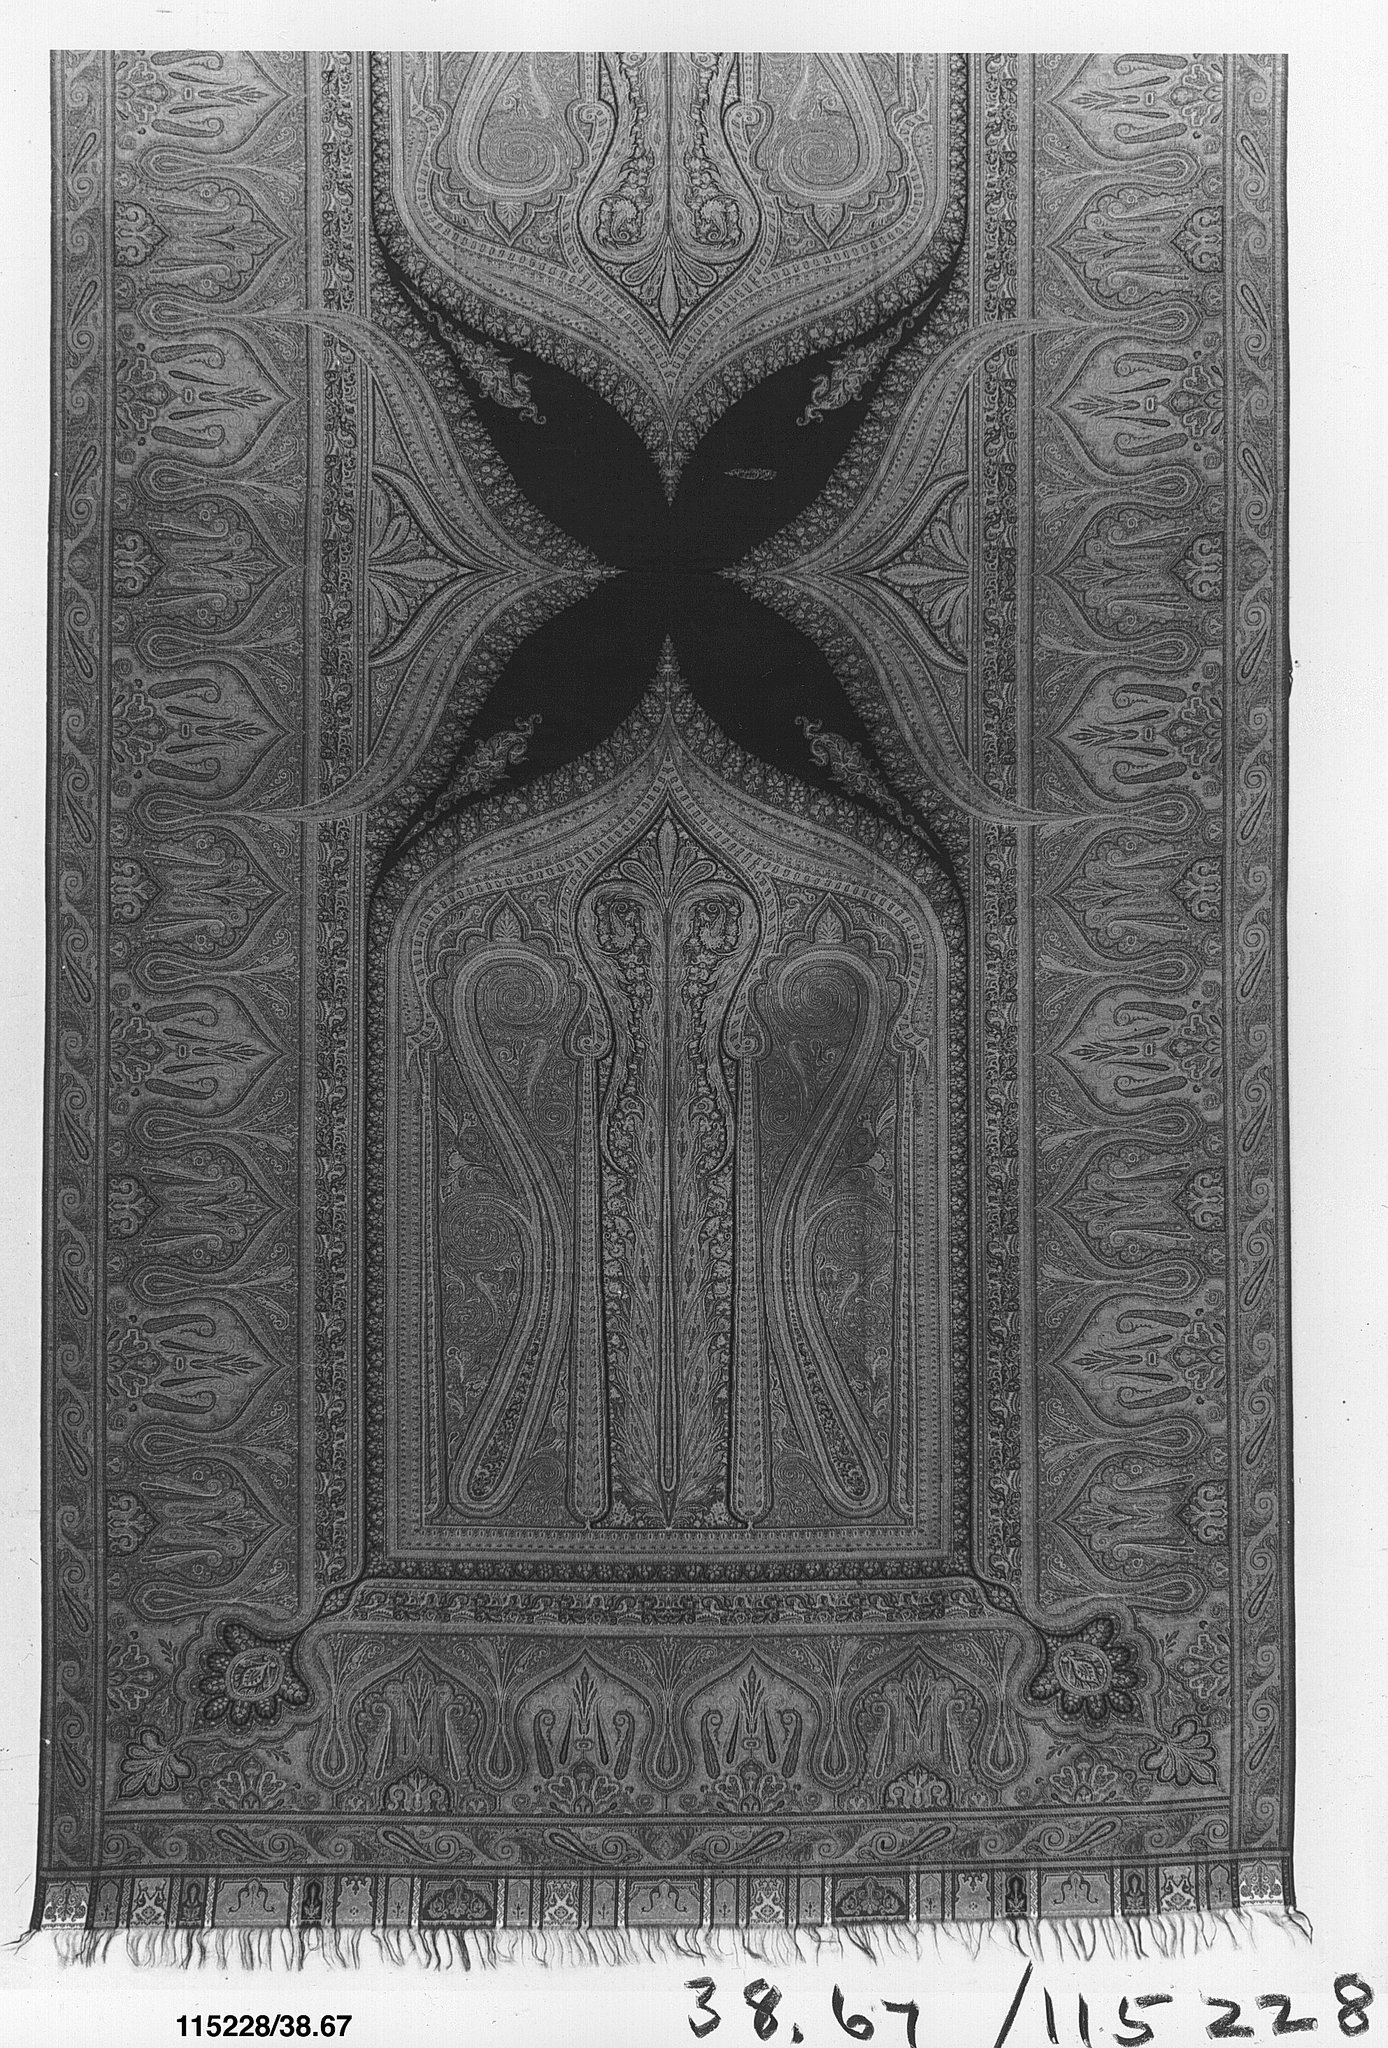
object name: shawl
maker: emile-frédéric hébert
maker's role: workshop director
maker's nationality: french, active 1851–1867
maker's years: 1851-1867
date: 1860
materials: silk, wool